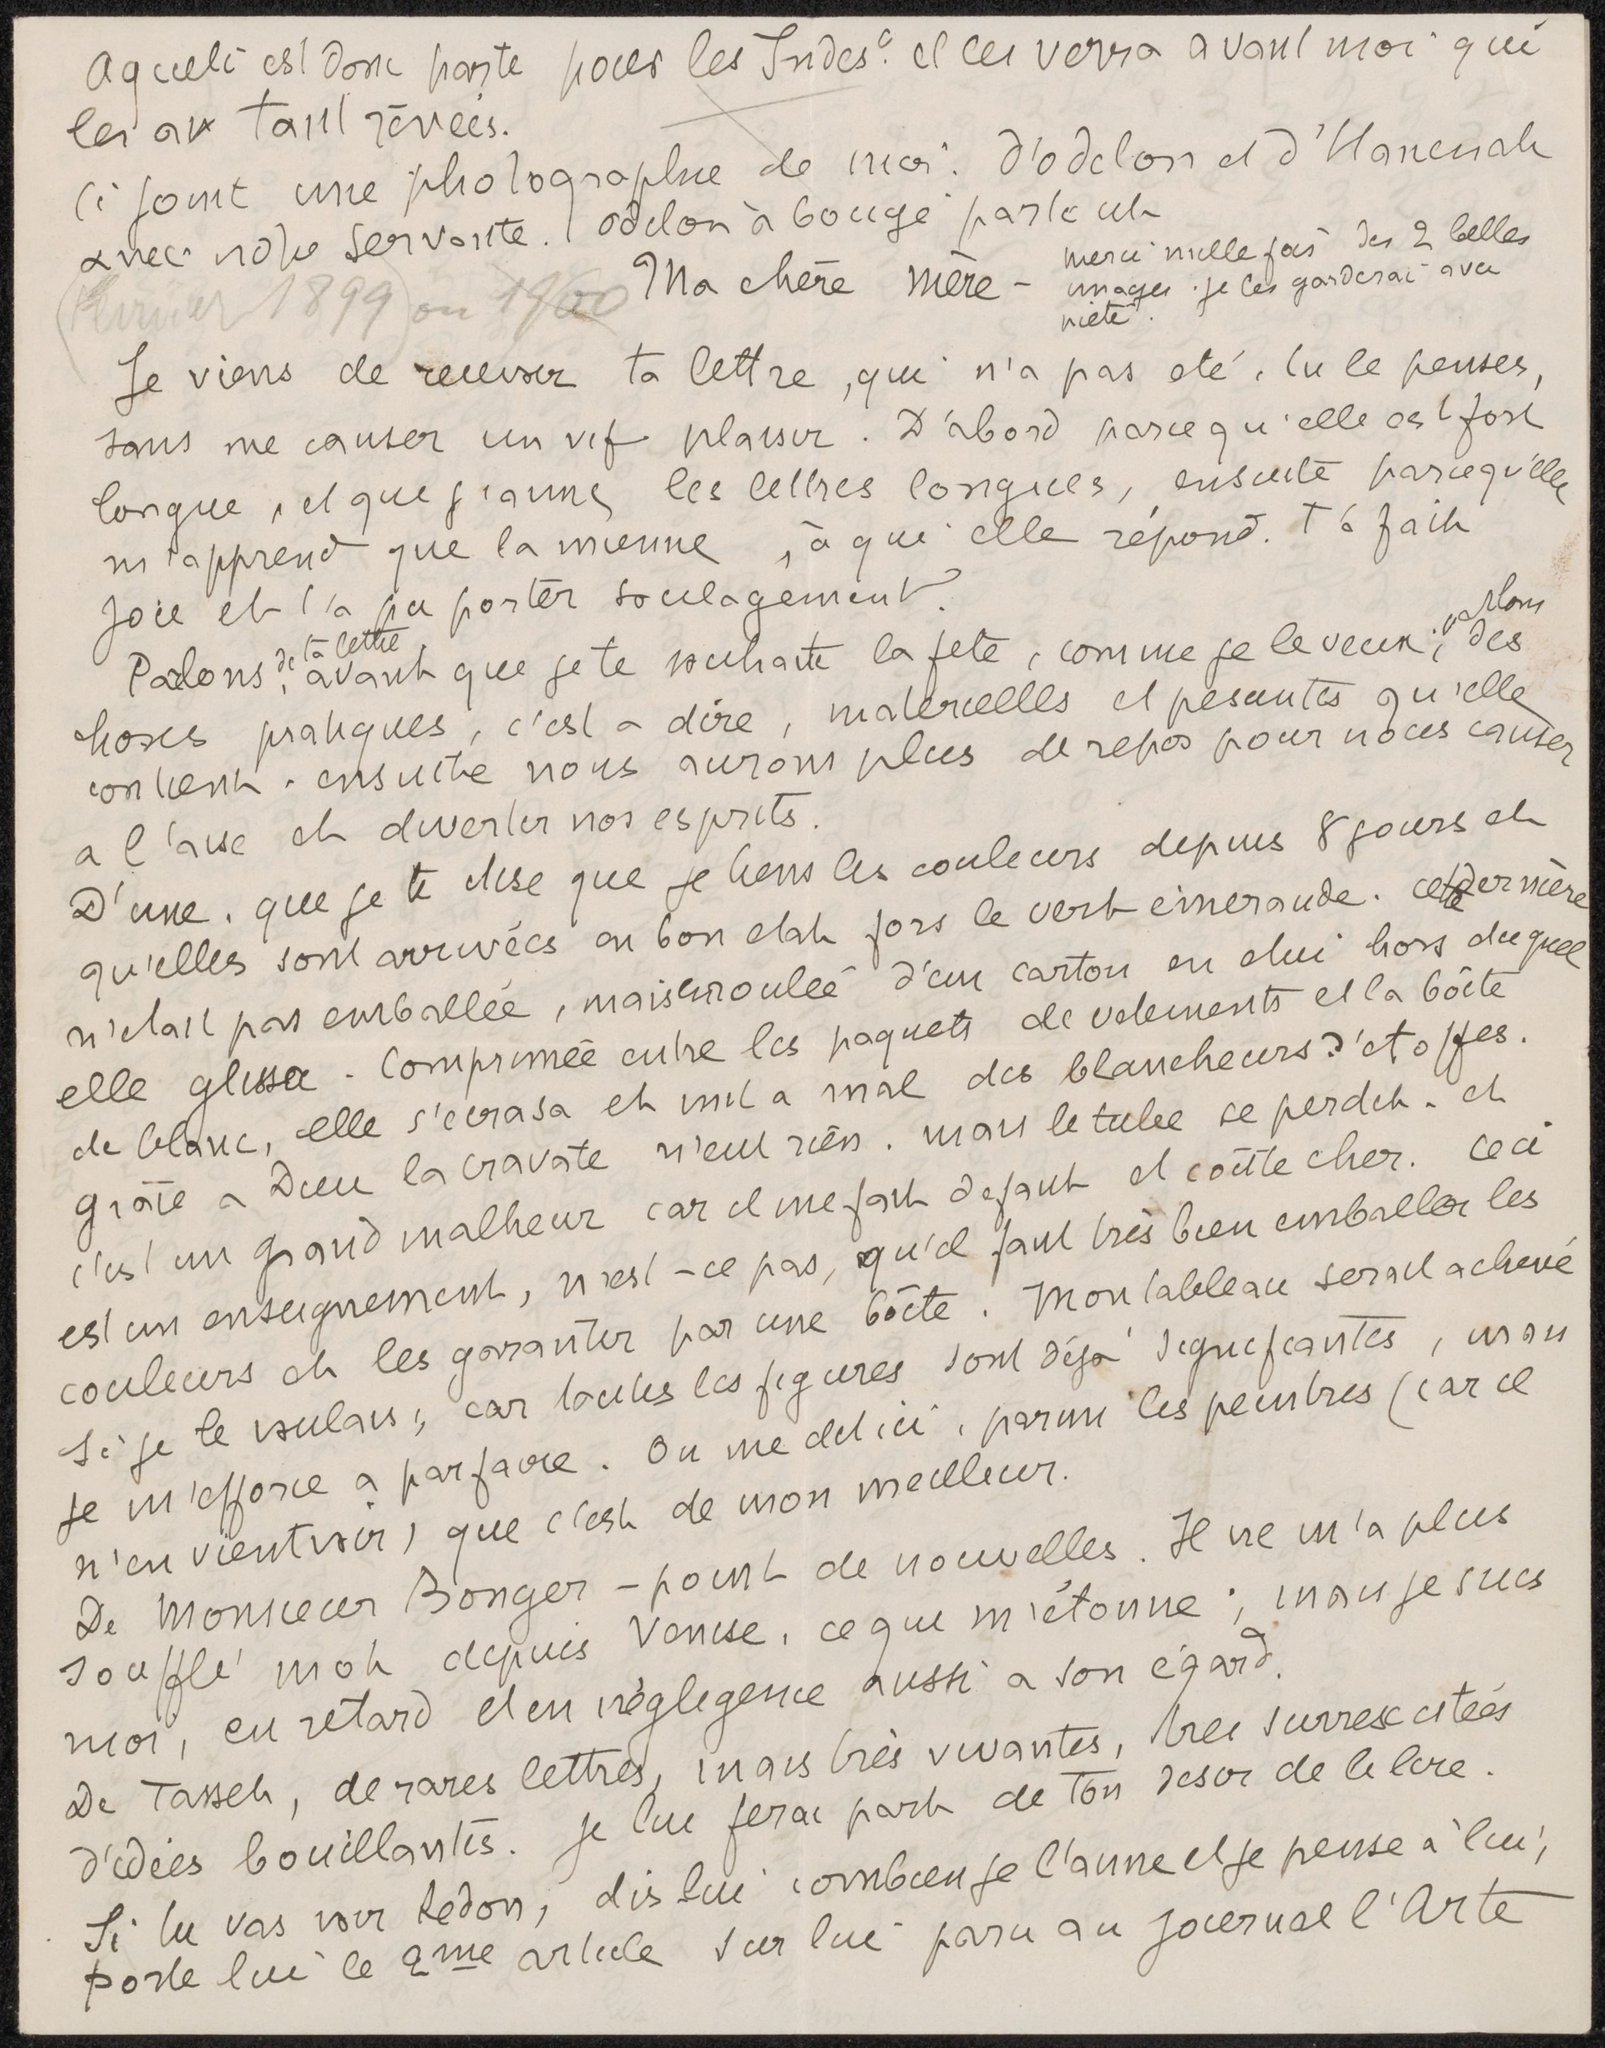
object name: letter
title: Brief aan Héloïse Bernard-Bodin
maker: émile bernard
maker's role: print maker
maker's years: 1868-1941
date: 1878-1941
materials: ink, paper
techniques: pen, writing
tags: héloïse bernard-bodin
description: Brief gedateerd fevrier 1899 in latere hand.